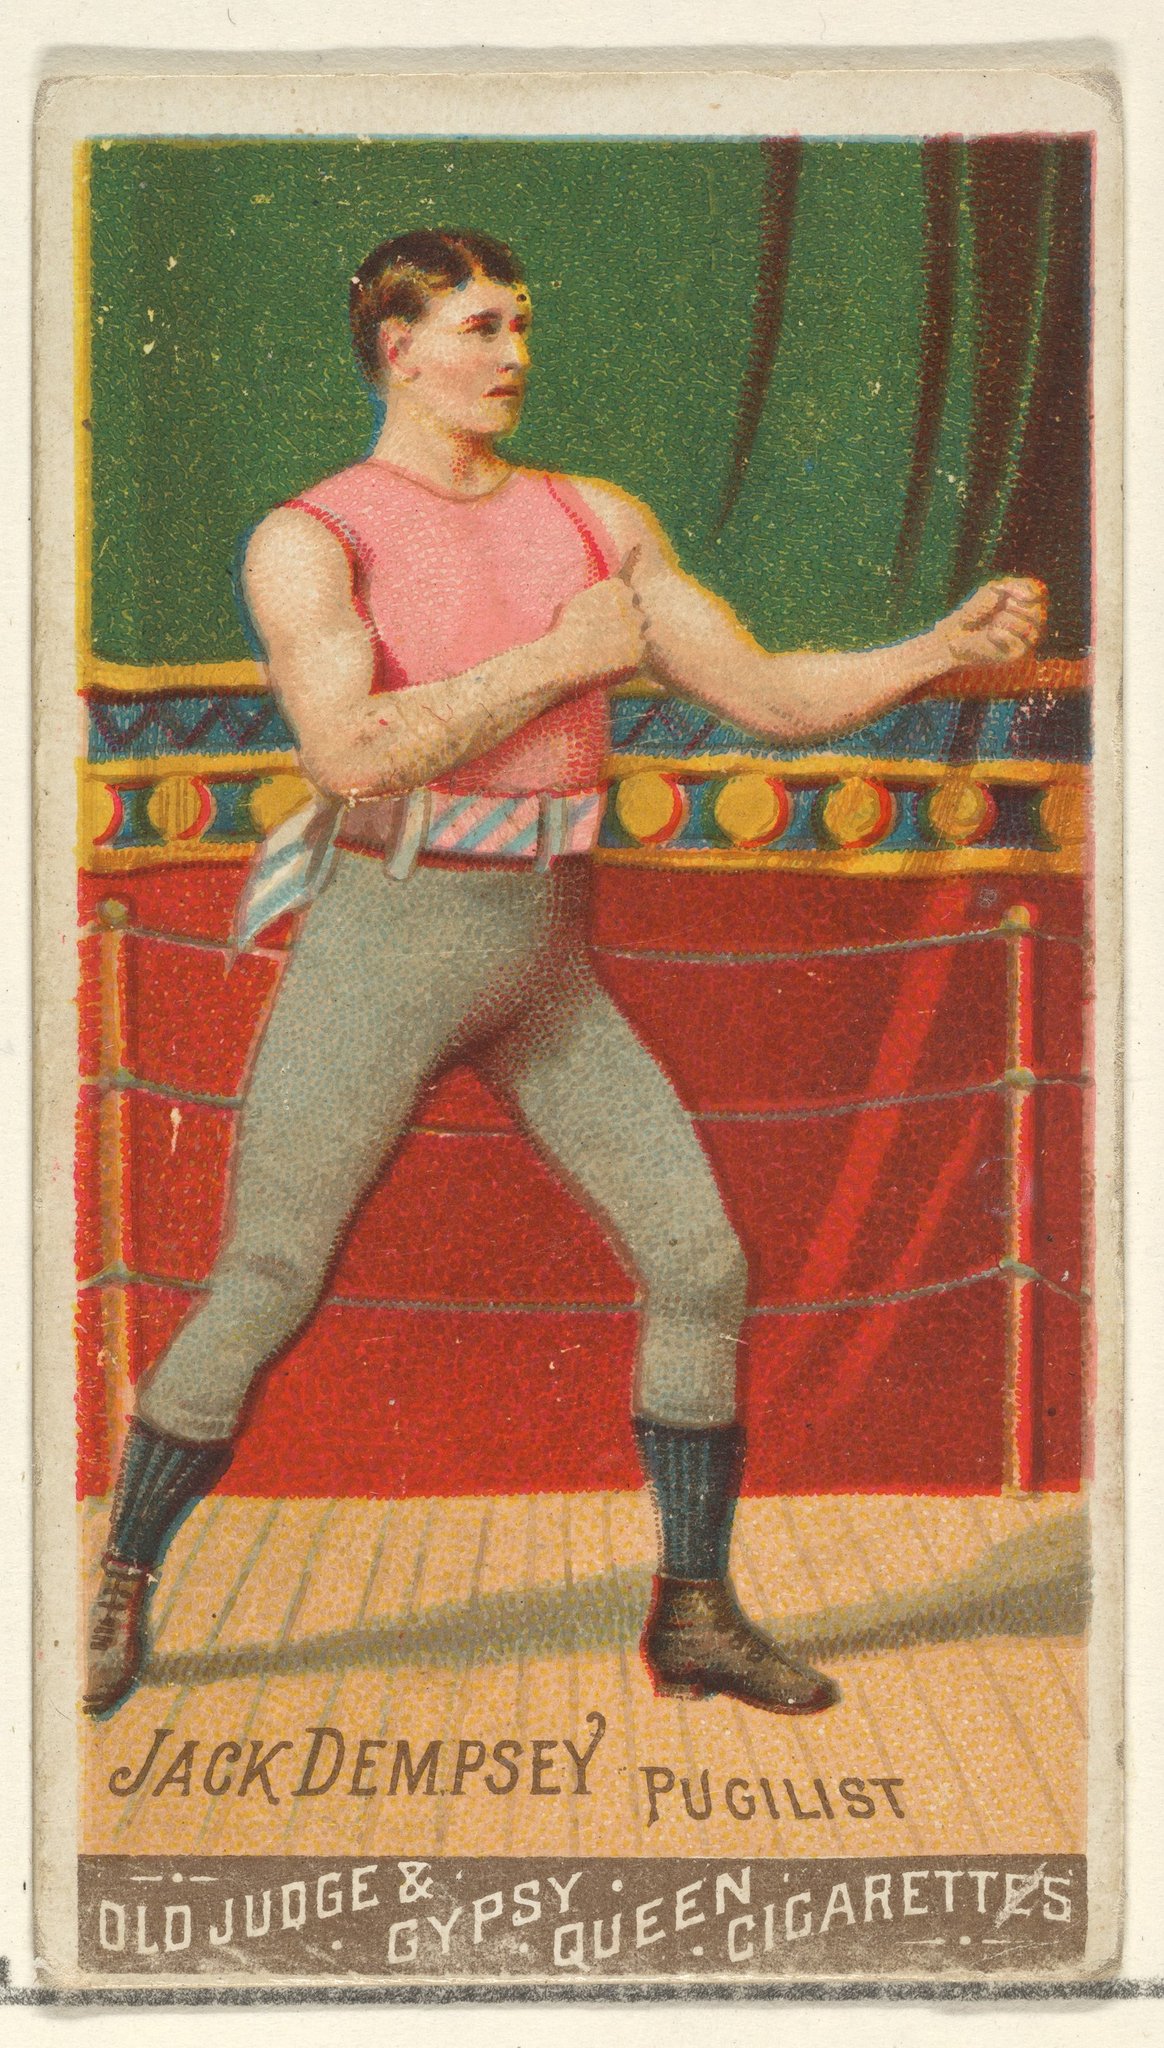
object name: print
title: Jack Dempsey, Pugilist, from the Goodwin Champion series for Old Judge and Gypsy Queen Cigarettes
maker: goodwin & company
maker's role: publisher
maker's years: 1850-1950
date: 1888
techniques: color lithograph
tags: men,portraits,boxing,athletes